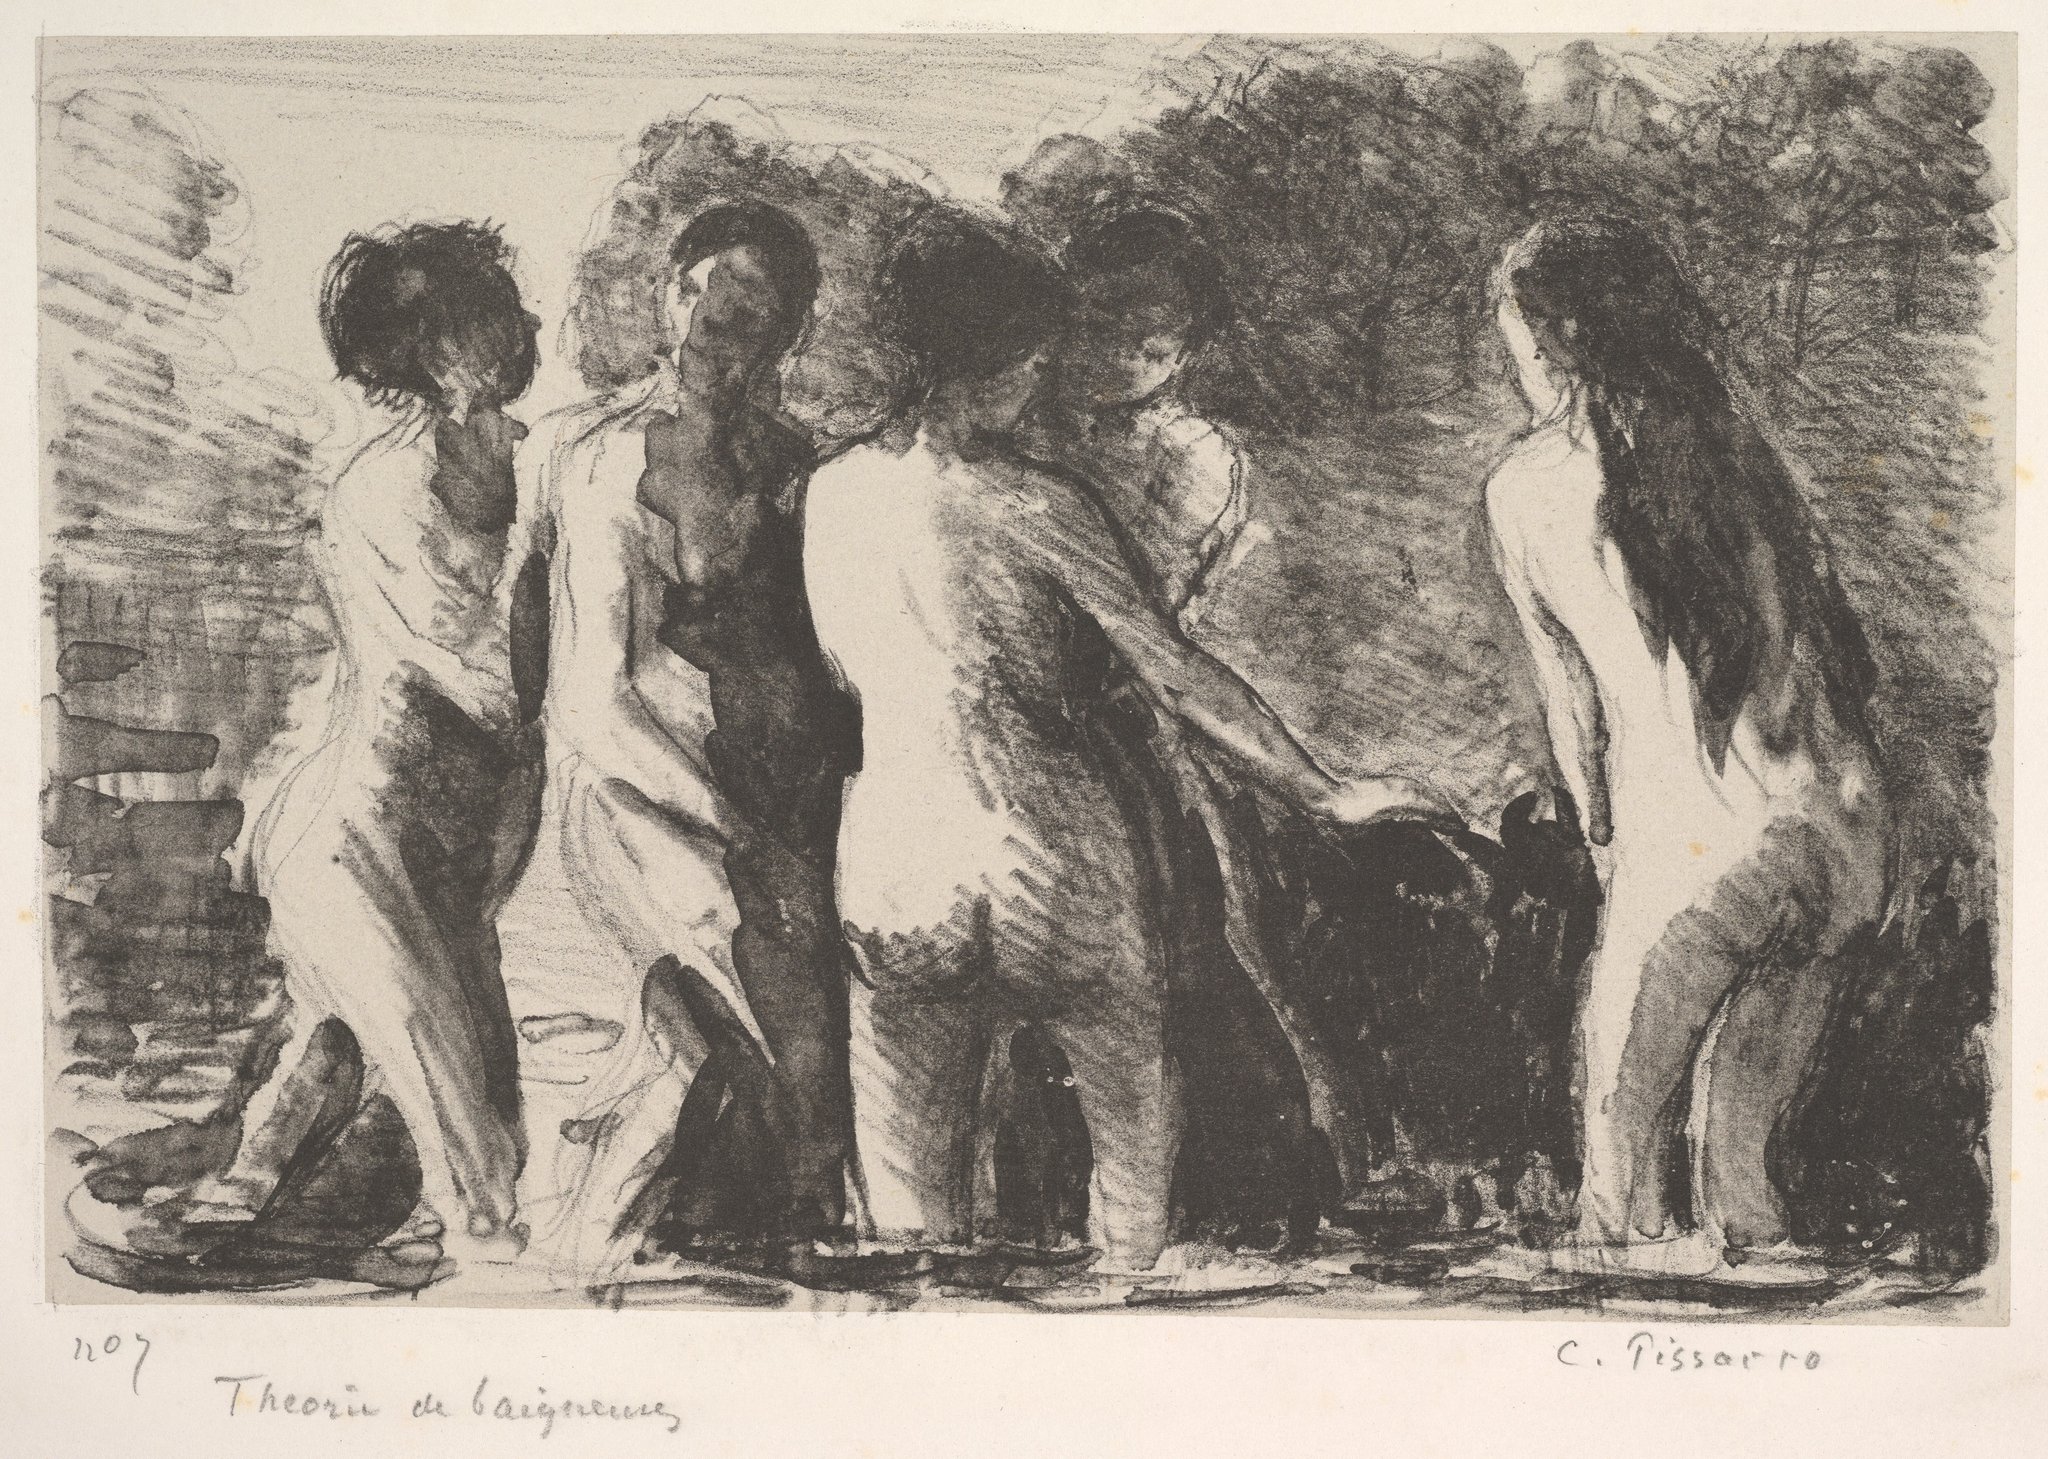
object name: print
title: Group of Bathers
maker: camille pissarro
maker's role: artist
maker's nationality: french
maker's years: 1830-1903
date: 1897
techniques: printmaking, lithograph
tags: female nudes,bathing